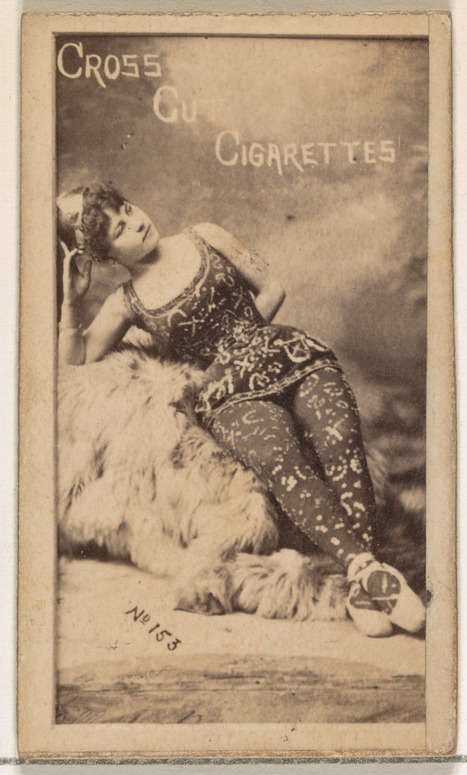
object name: print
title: Card Number 153, from the Actors and Actresses series (N145-1) issued by Duke Sons & Co. to promote Cross Cut Cigarettes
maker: w. duke, sons & co.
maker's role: publisher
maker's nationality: american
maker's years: 1870-1920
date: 1880-1889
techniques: albumen silver print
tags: portraits,women,actresses